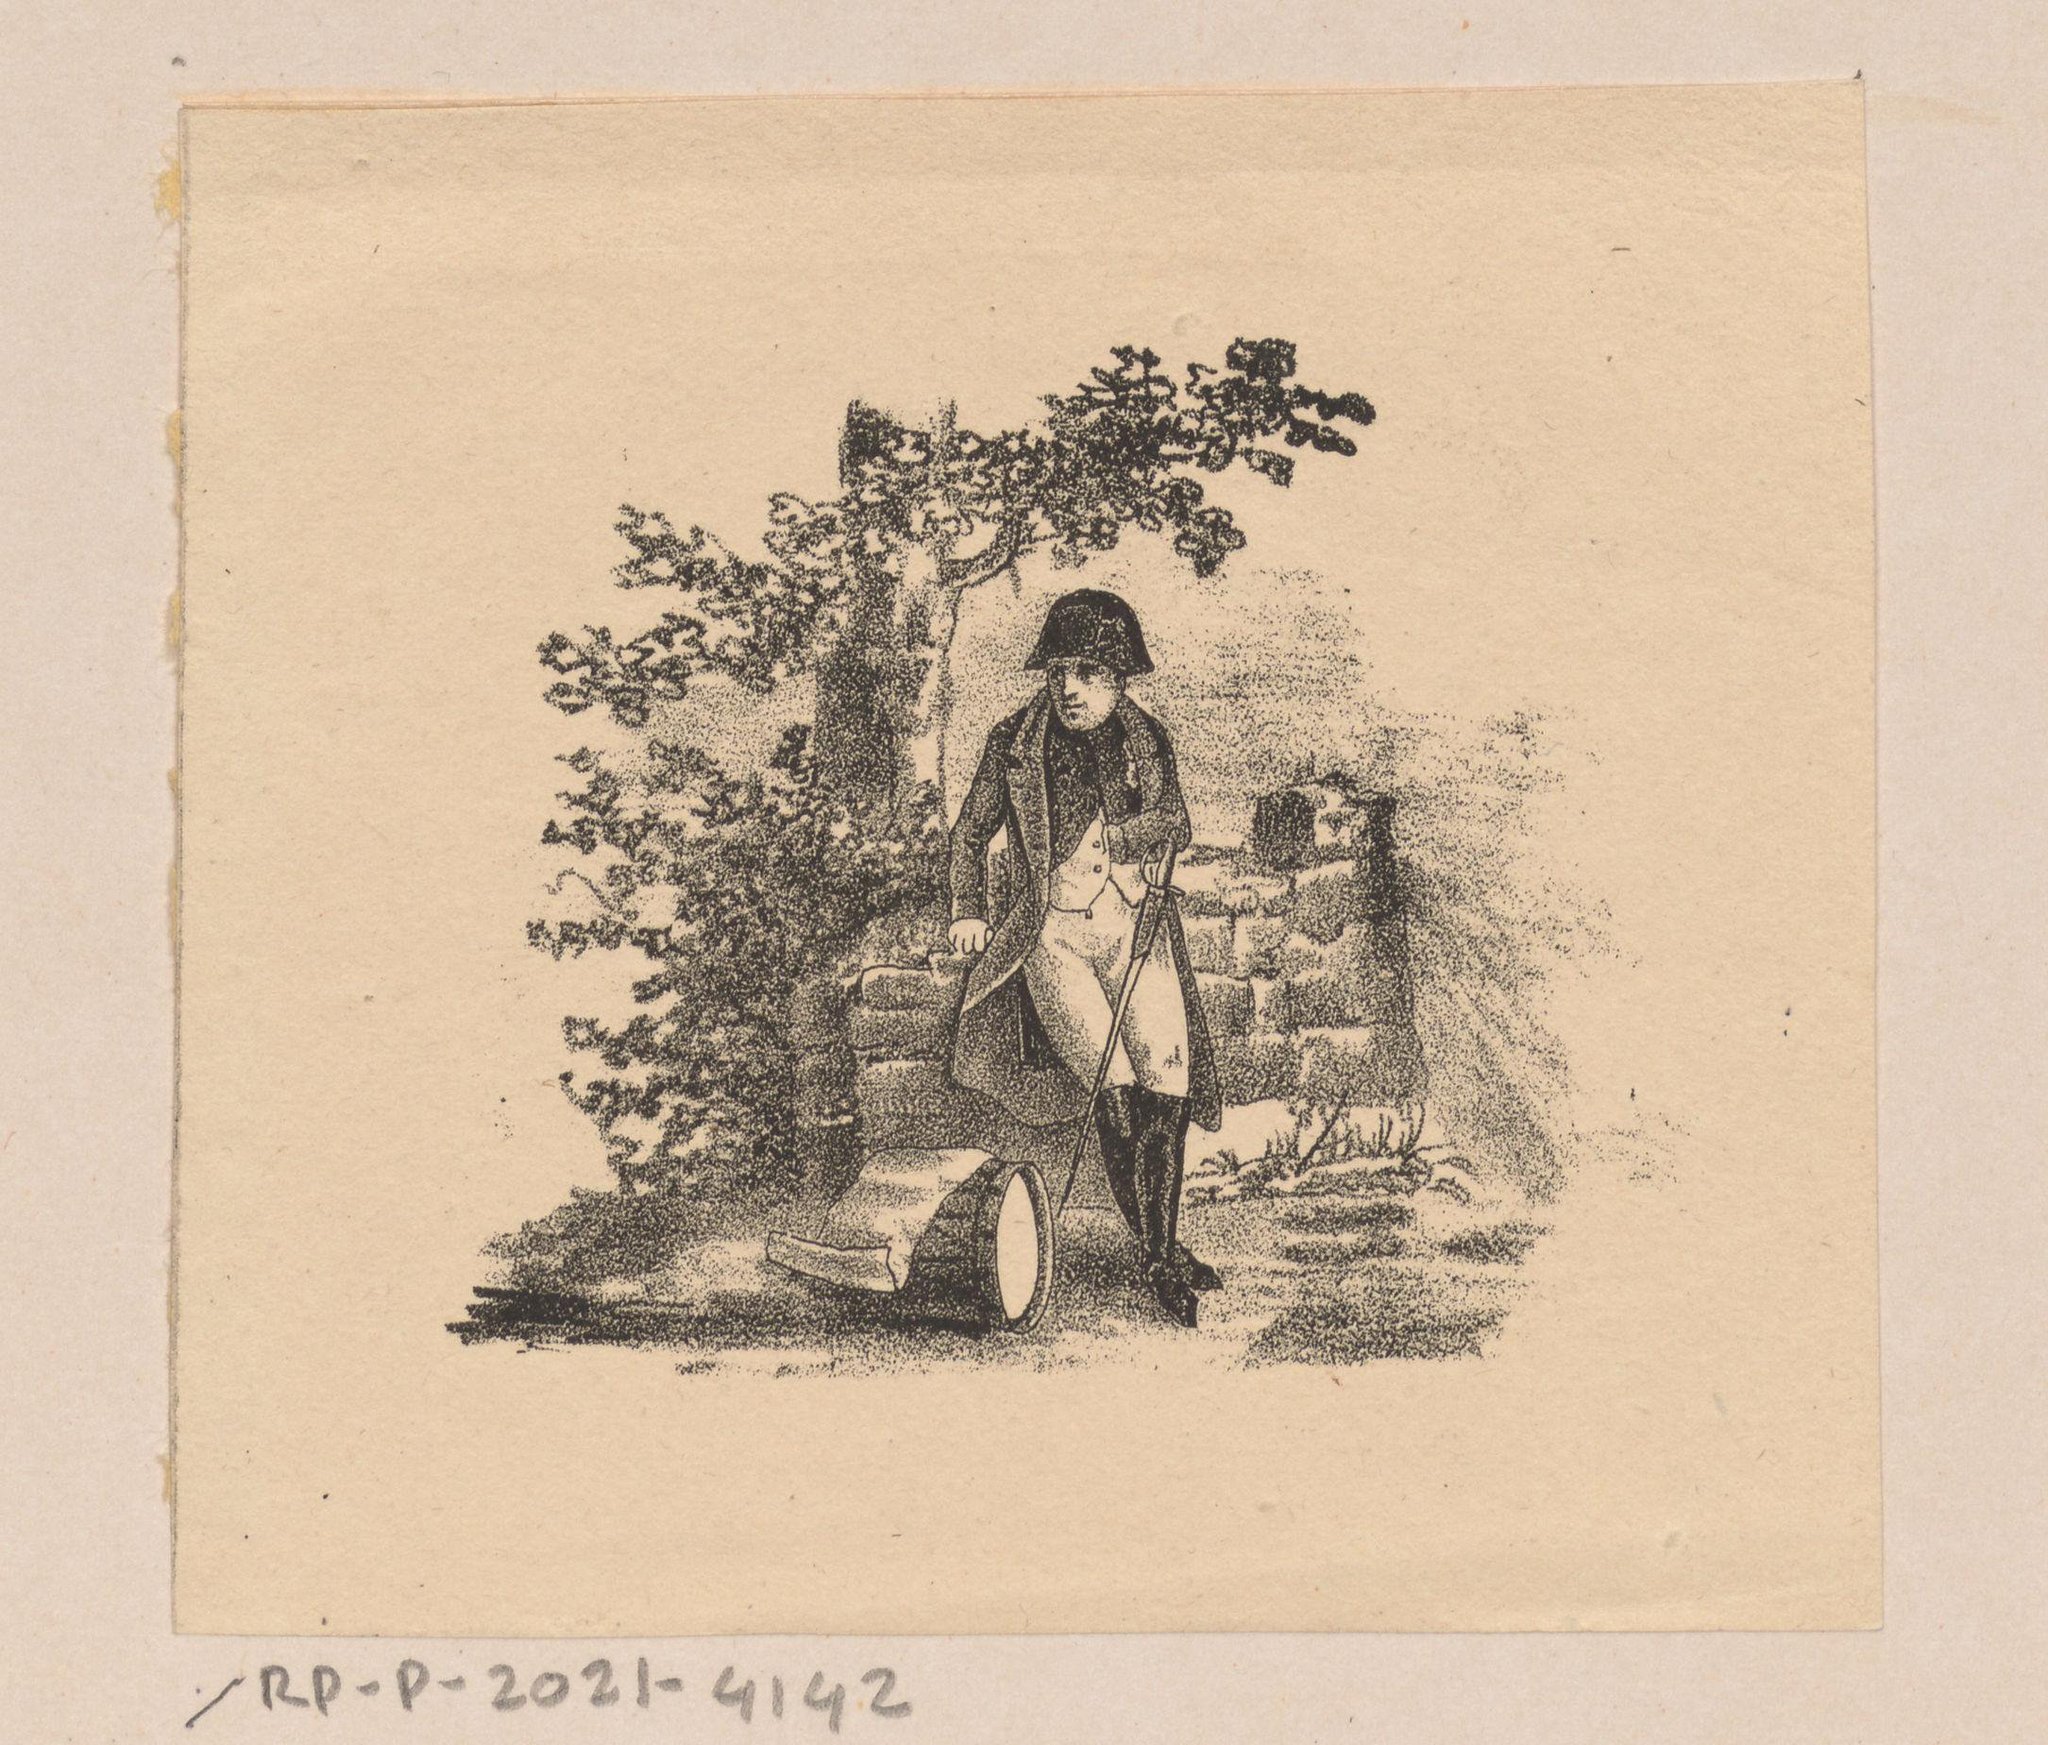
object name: print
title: Portret van Napoleon I Bonaparte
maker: Anonymous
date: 1804-1899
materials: paper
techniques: lithograph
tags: napoleon i (emperor of the french), fence, wall, paling, historical persons, emperor, paper (writing material)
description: Leunend tegen een stenen muur met aan zijn voeten een stuk papier op een trommel.